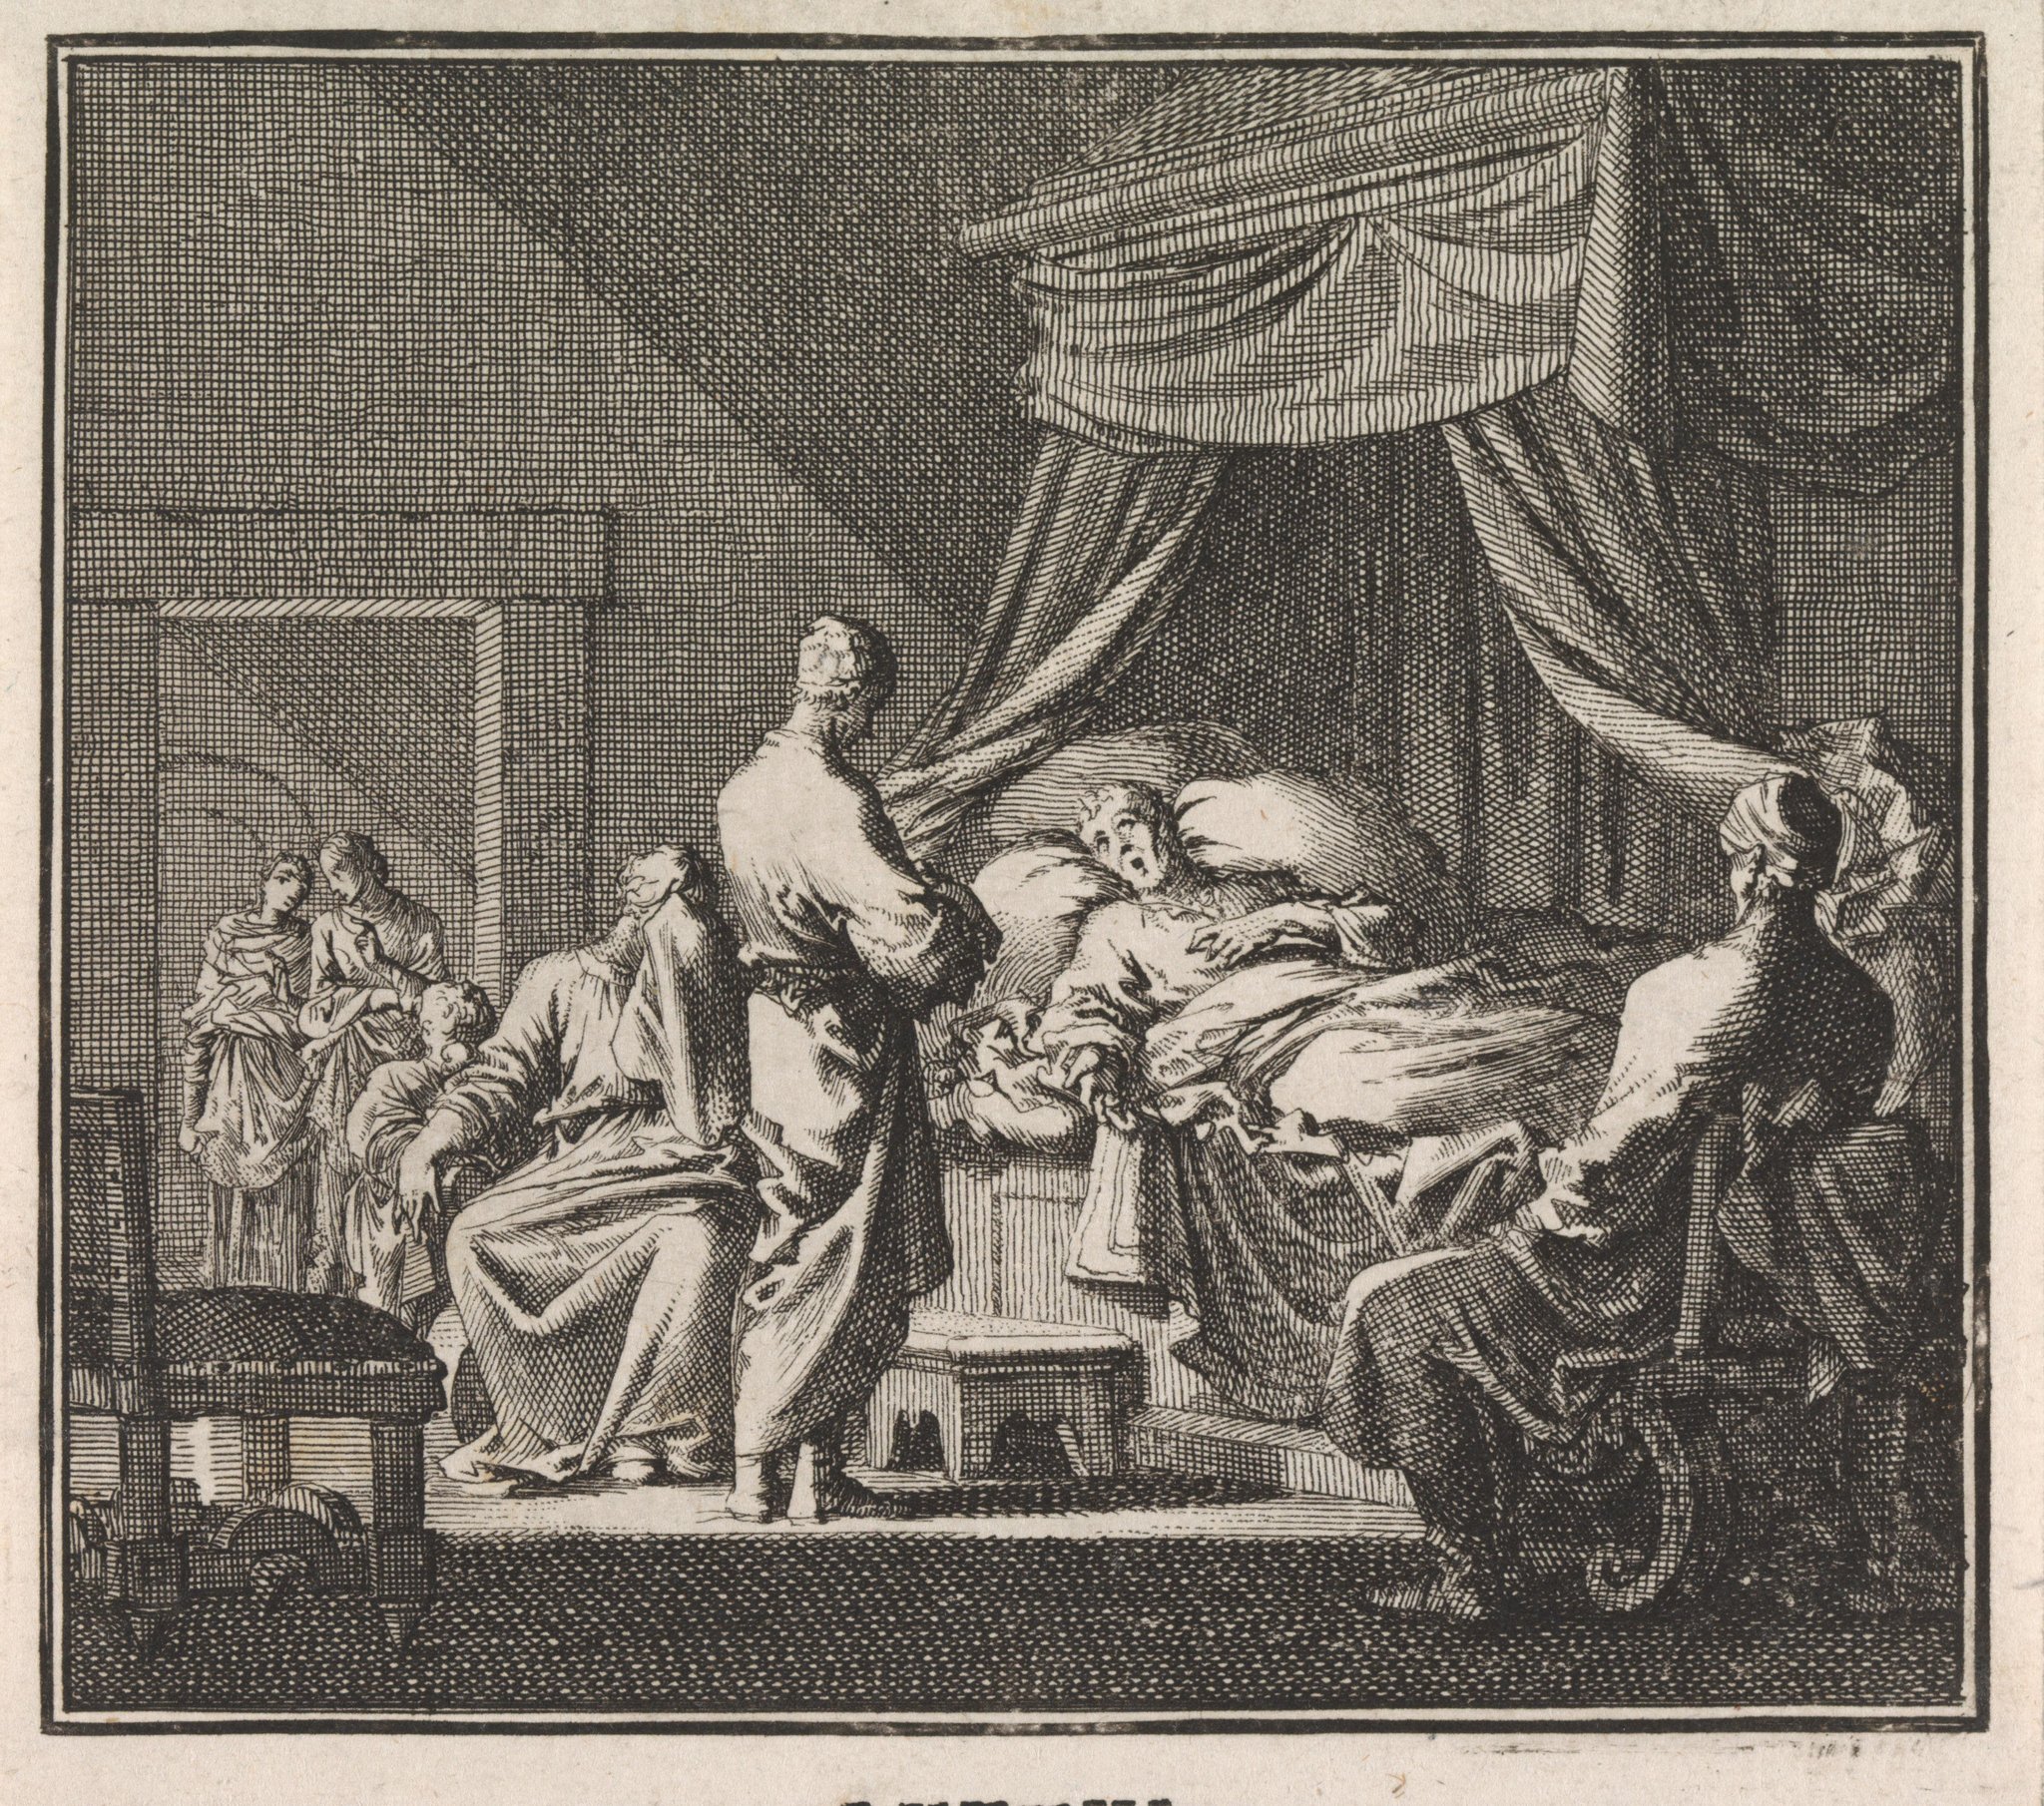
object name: print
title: Ziekenbezoek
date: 1695-1705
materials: paper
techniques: etching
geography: nuremberg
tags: sick-bed, interior of the house, patient, sick person, visiting the sick; sick person together with others, abstract ideas and concepts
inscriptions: collector's mark: Lugt 2228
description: Boekillustratie voor Weigel, Christoph. Ethica Naturalis seu Documenta Moralia e Variis rerum Naturalium proprietatibus Virtutum Vitiorumq symbolicis imaginibus collecta. Neurenberg: Christoph Weigel: c. 1700.